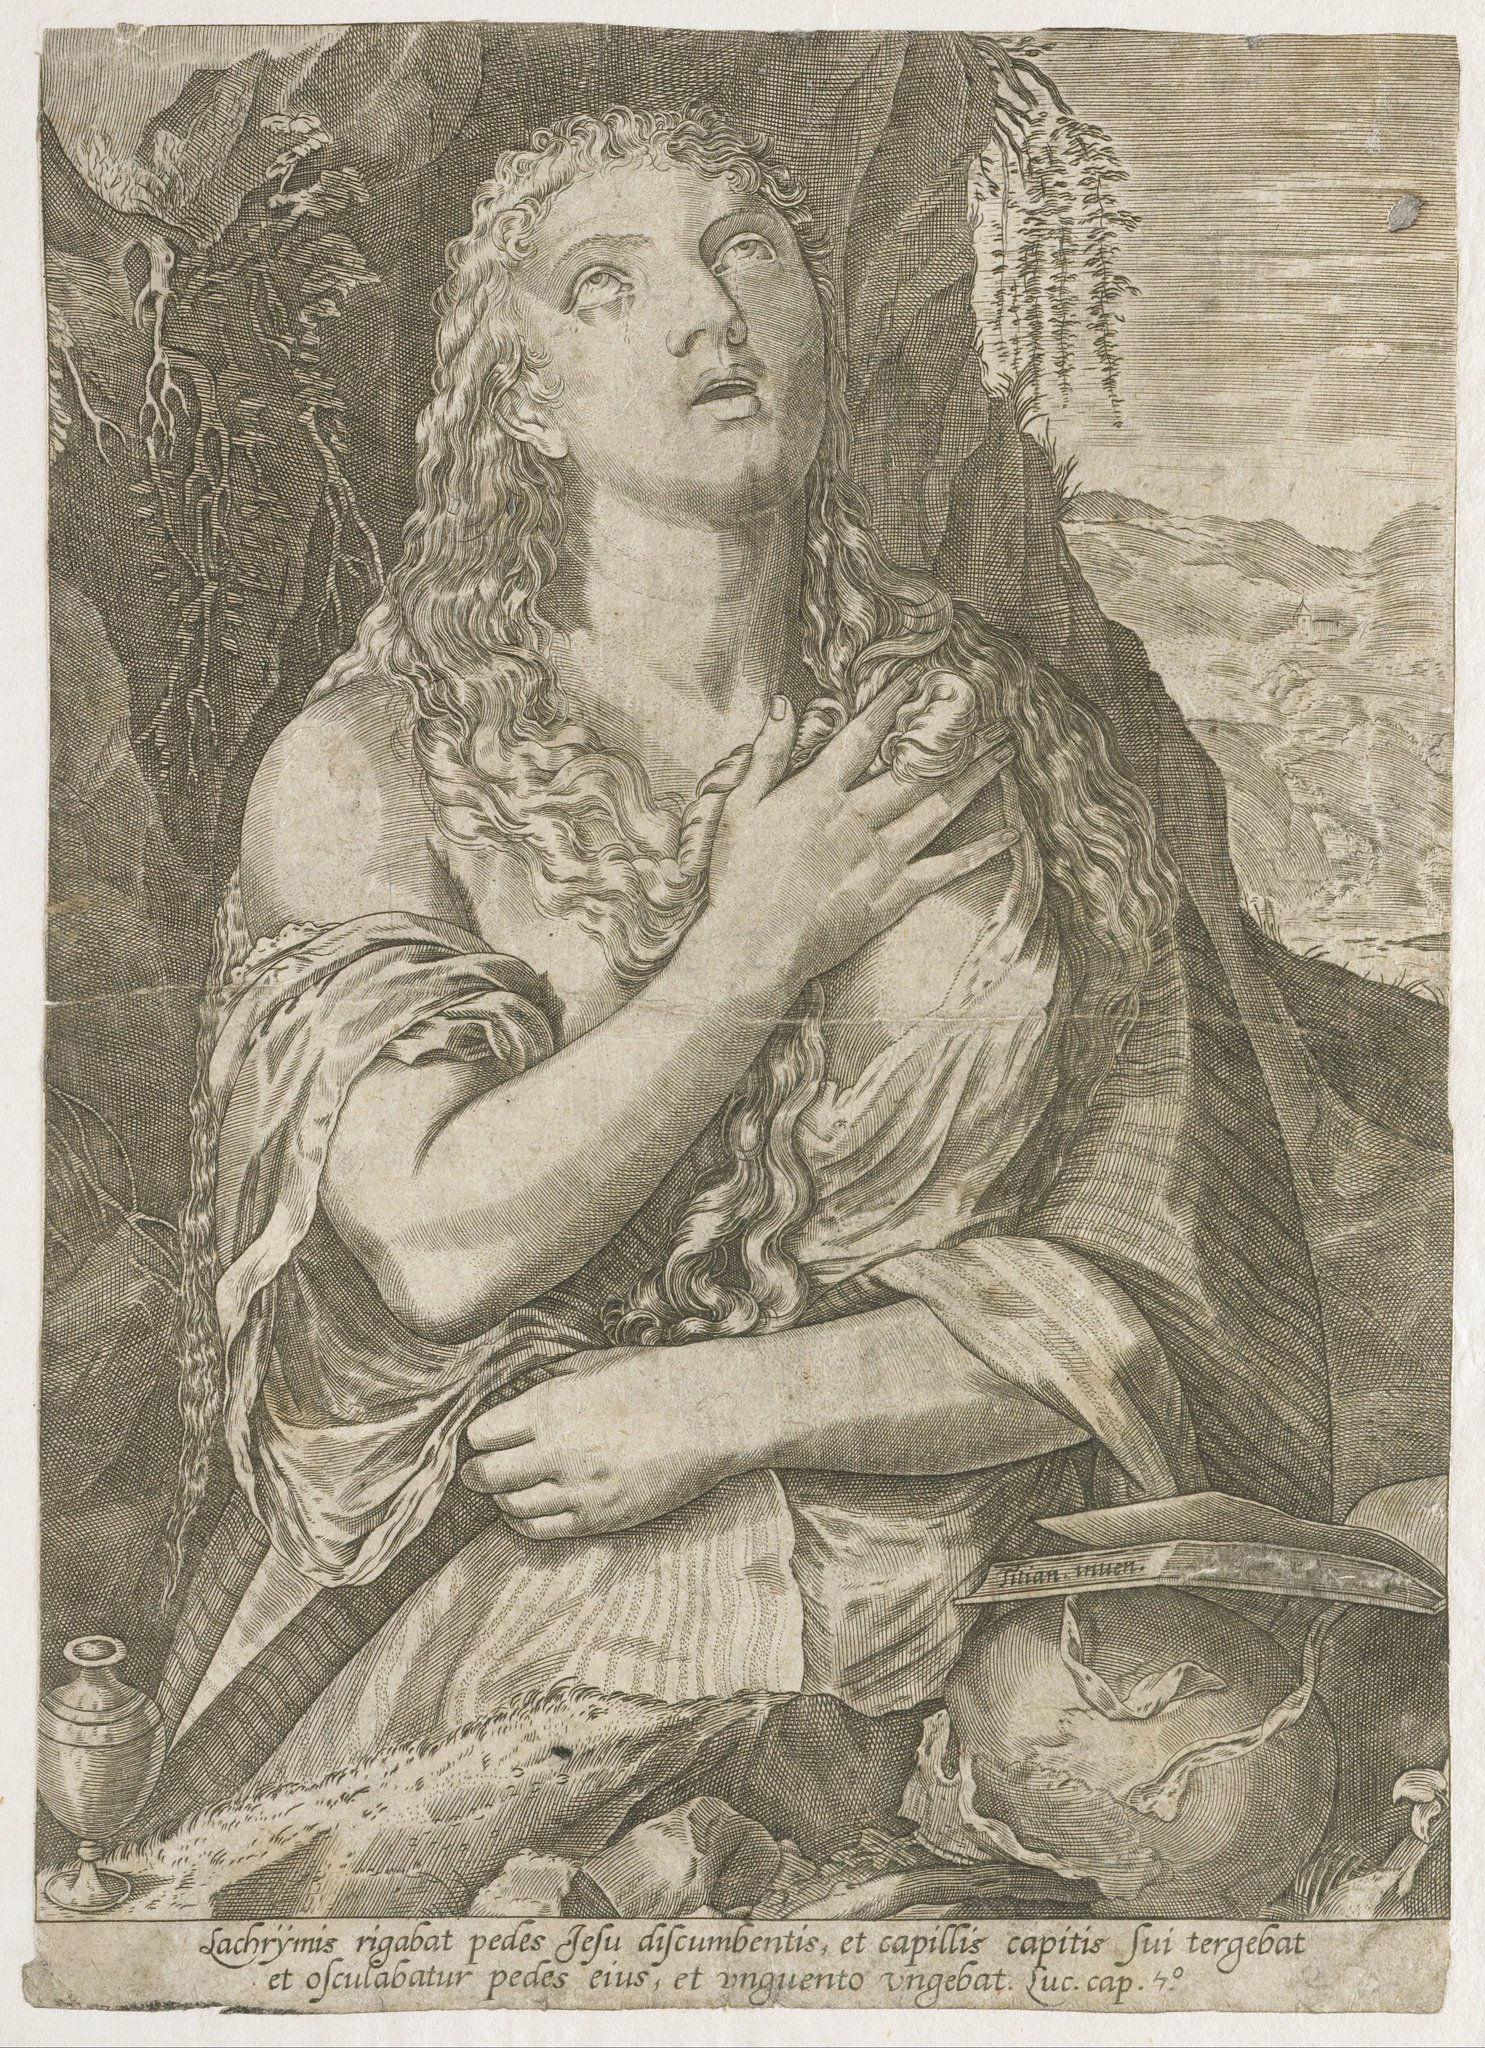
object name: print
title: De boetvaardige Maria Magdalena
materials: paper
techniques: engraving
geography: rome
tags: the penitent harlot mary magdalene; possible attributes: book (or scroll), crown, crown of thorns, crucifix, jar of ointment, mirror, musical instrument, palm-branch, rosary, scourge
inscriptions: collector's mark: Lugt 2228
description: Maria Magdalena bidt op een afgelegen plek bij een grot. Ze slaat haar ogen naar de hemel en houdt een hand voor de borst. Naast haar het zalfpotje waarmee ze de voeten van Christus heeft gezalfd.